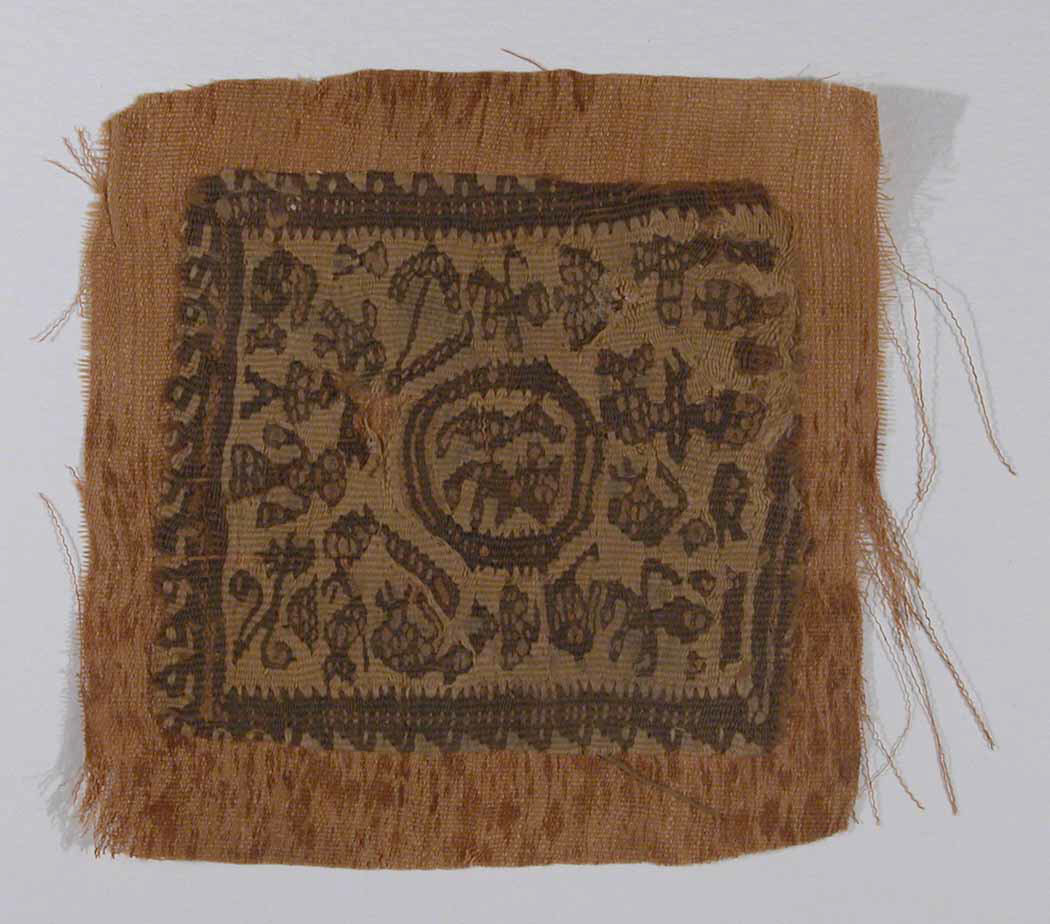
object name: panel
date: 501-700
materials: linen, wool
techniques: tapestry, weave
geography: egypt